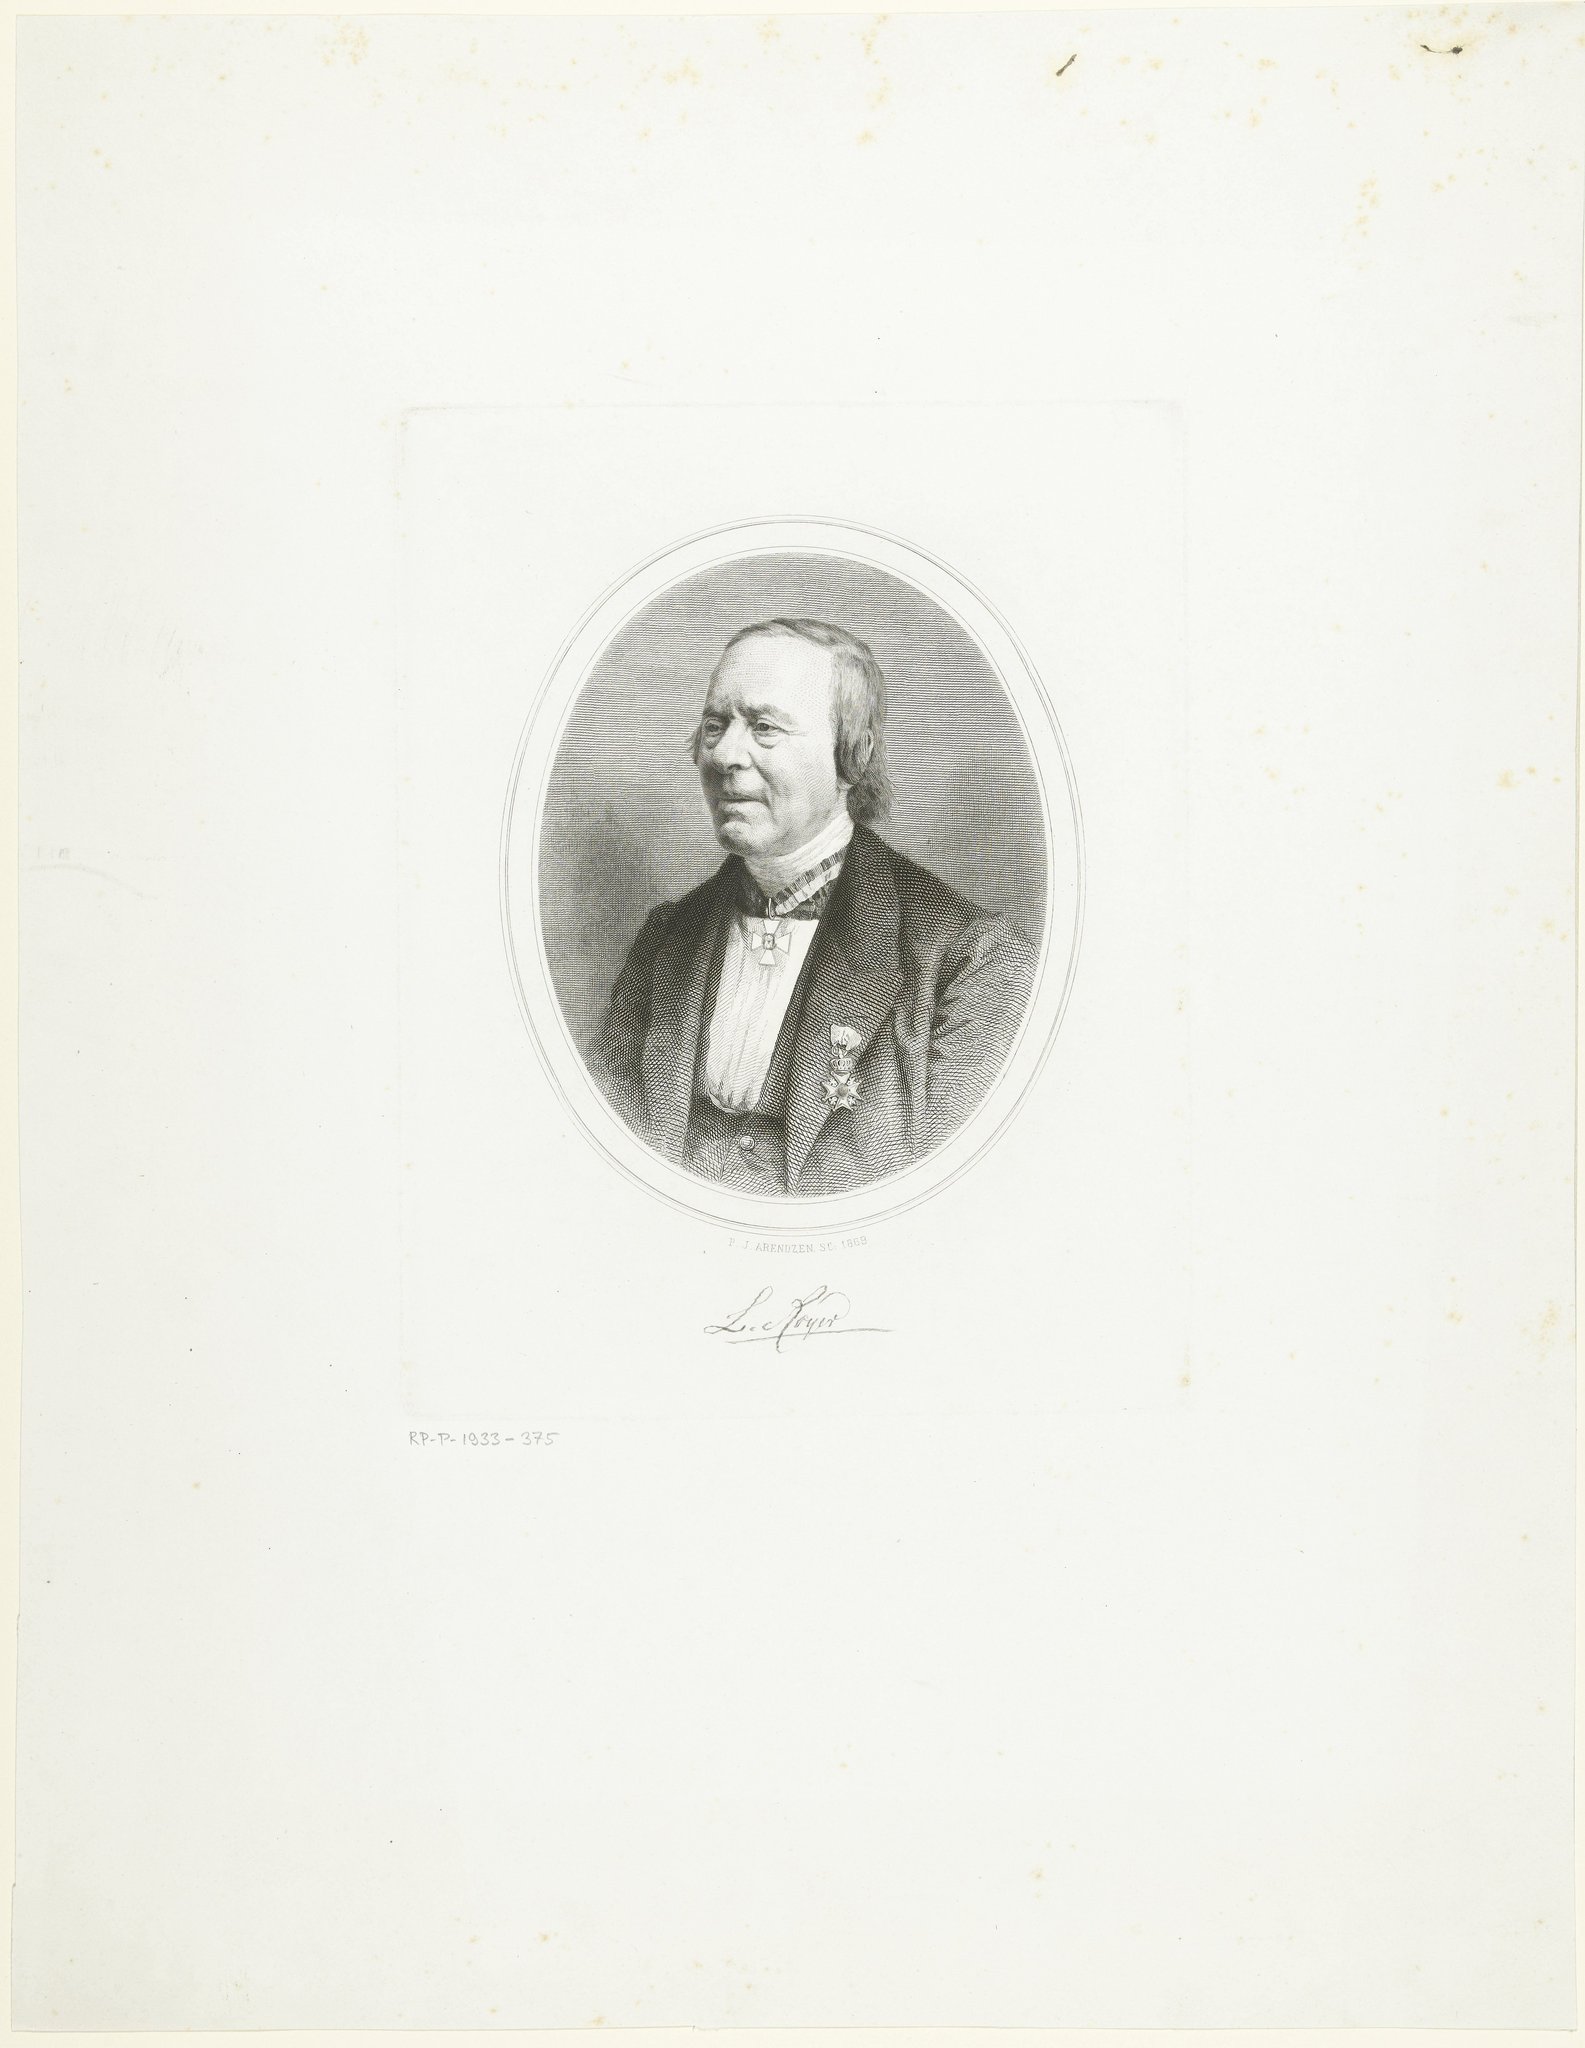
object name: print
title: Portret van Louis Royer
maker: petrus johannes arendzen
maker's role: draughtsman, print maker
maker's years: 1846-1932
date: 1869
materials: paper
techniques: engraving, etching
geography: netherlands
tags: mechelen, amsterdam, sculptor, louis royer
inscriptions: date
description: Borstbeeld van de beeldhouwer Louis Royer in ovaal. In de ondermarge een facsimile van zijn handtekening.